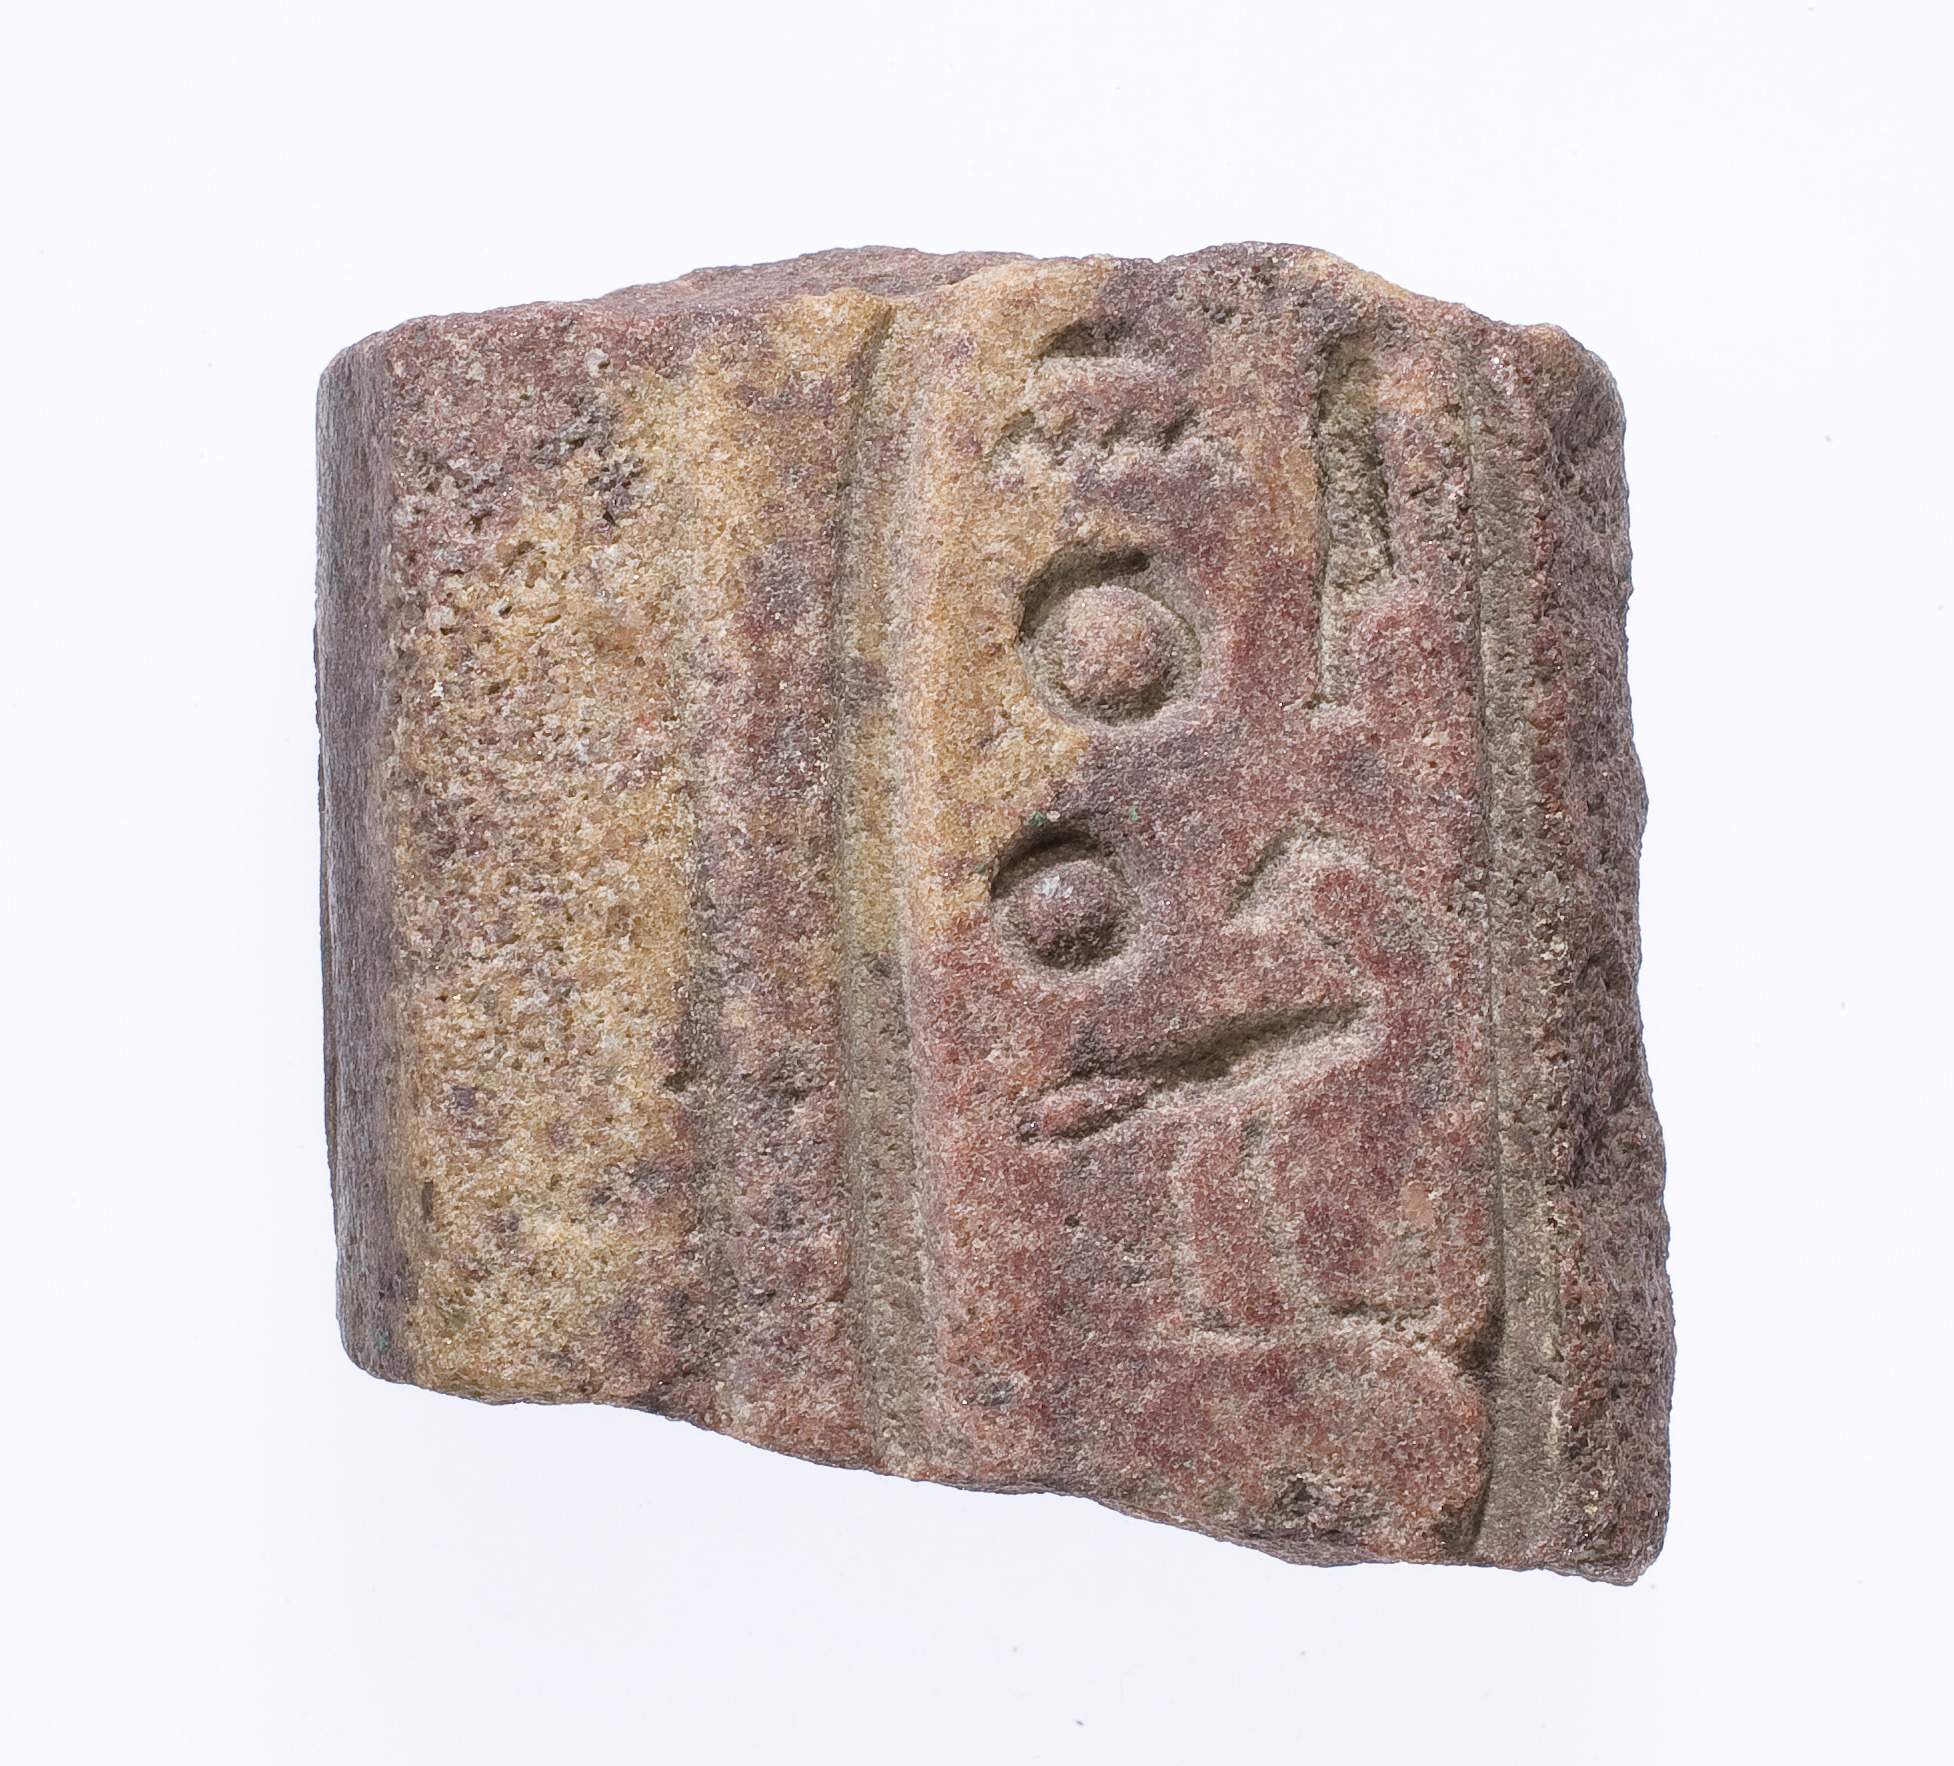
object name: cartouche of akhenaten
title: Fragment with the cartouche of Akhenaten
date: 1353-1336 BCE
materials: quartzite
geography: egypt